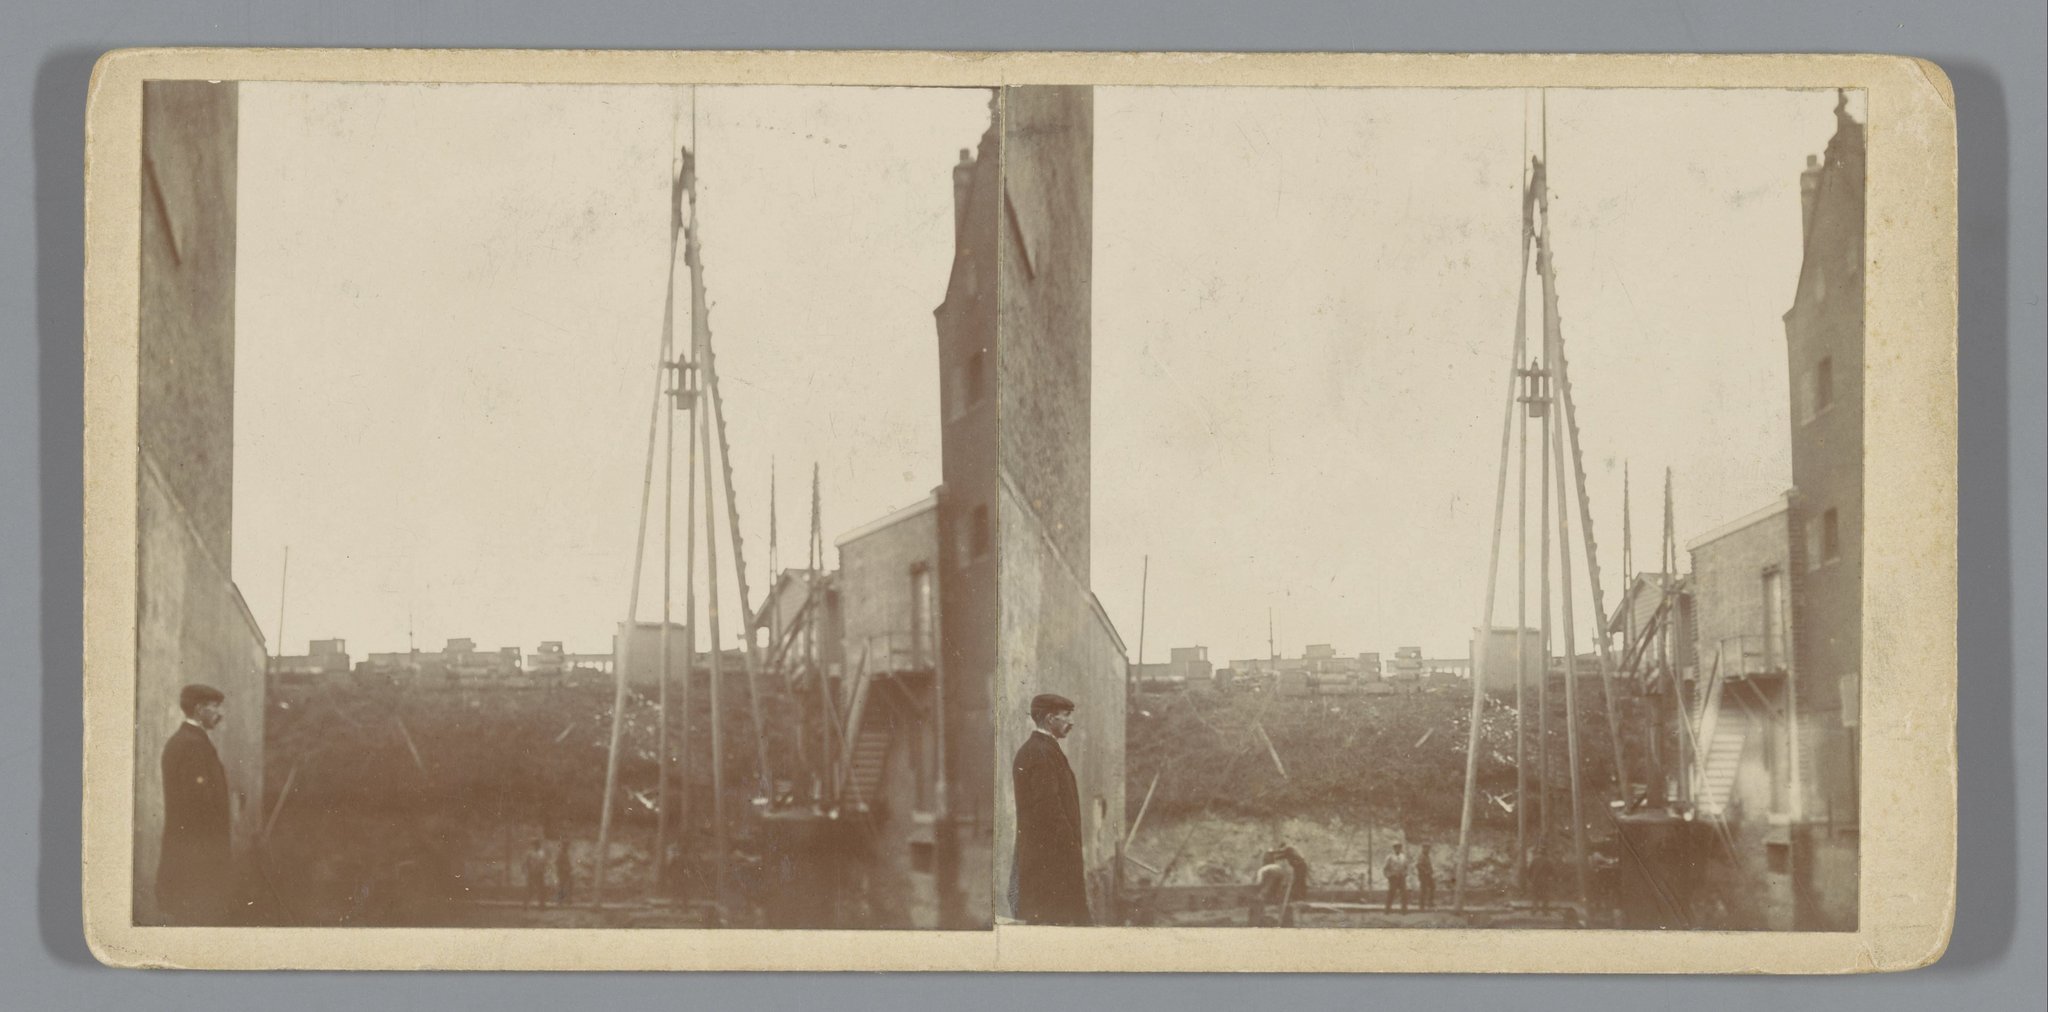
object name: stereograph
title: Bouwput in Amsterdam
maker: theo van heemstede obelt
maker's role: amateurfotograaf, architect, directeur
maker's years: 1857-1918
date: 1905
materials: paper, cardboard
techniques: gelatin silver print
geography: amsterdam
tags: building-site, amsterdam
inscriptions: inscription: ‘101-’, stamp: ‘TH. VAN HEEMSTEDE OBELT/ Amat. Fot./ AMSTERDAM.’